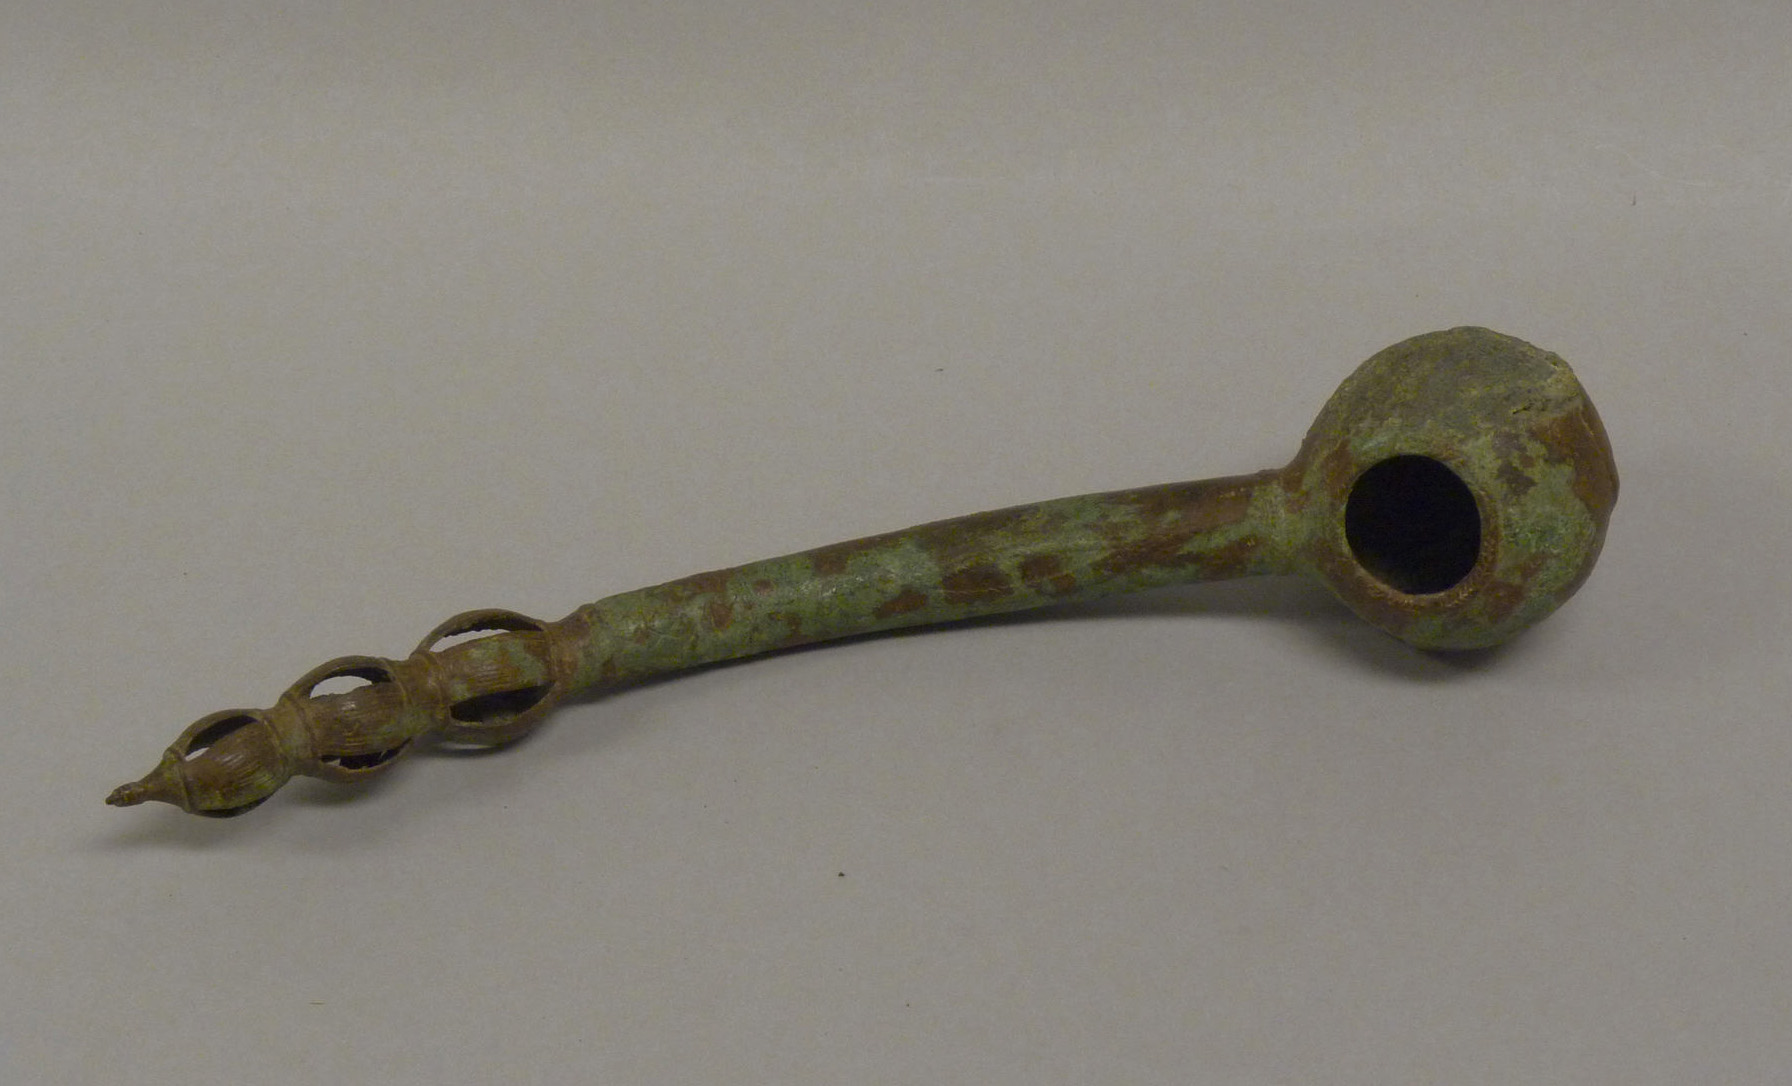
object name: ladle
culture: vietnamese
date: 500 BCE-300 CE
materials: bronze